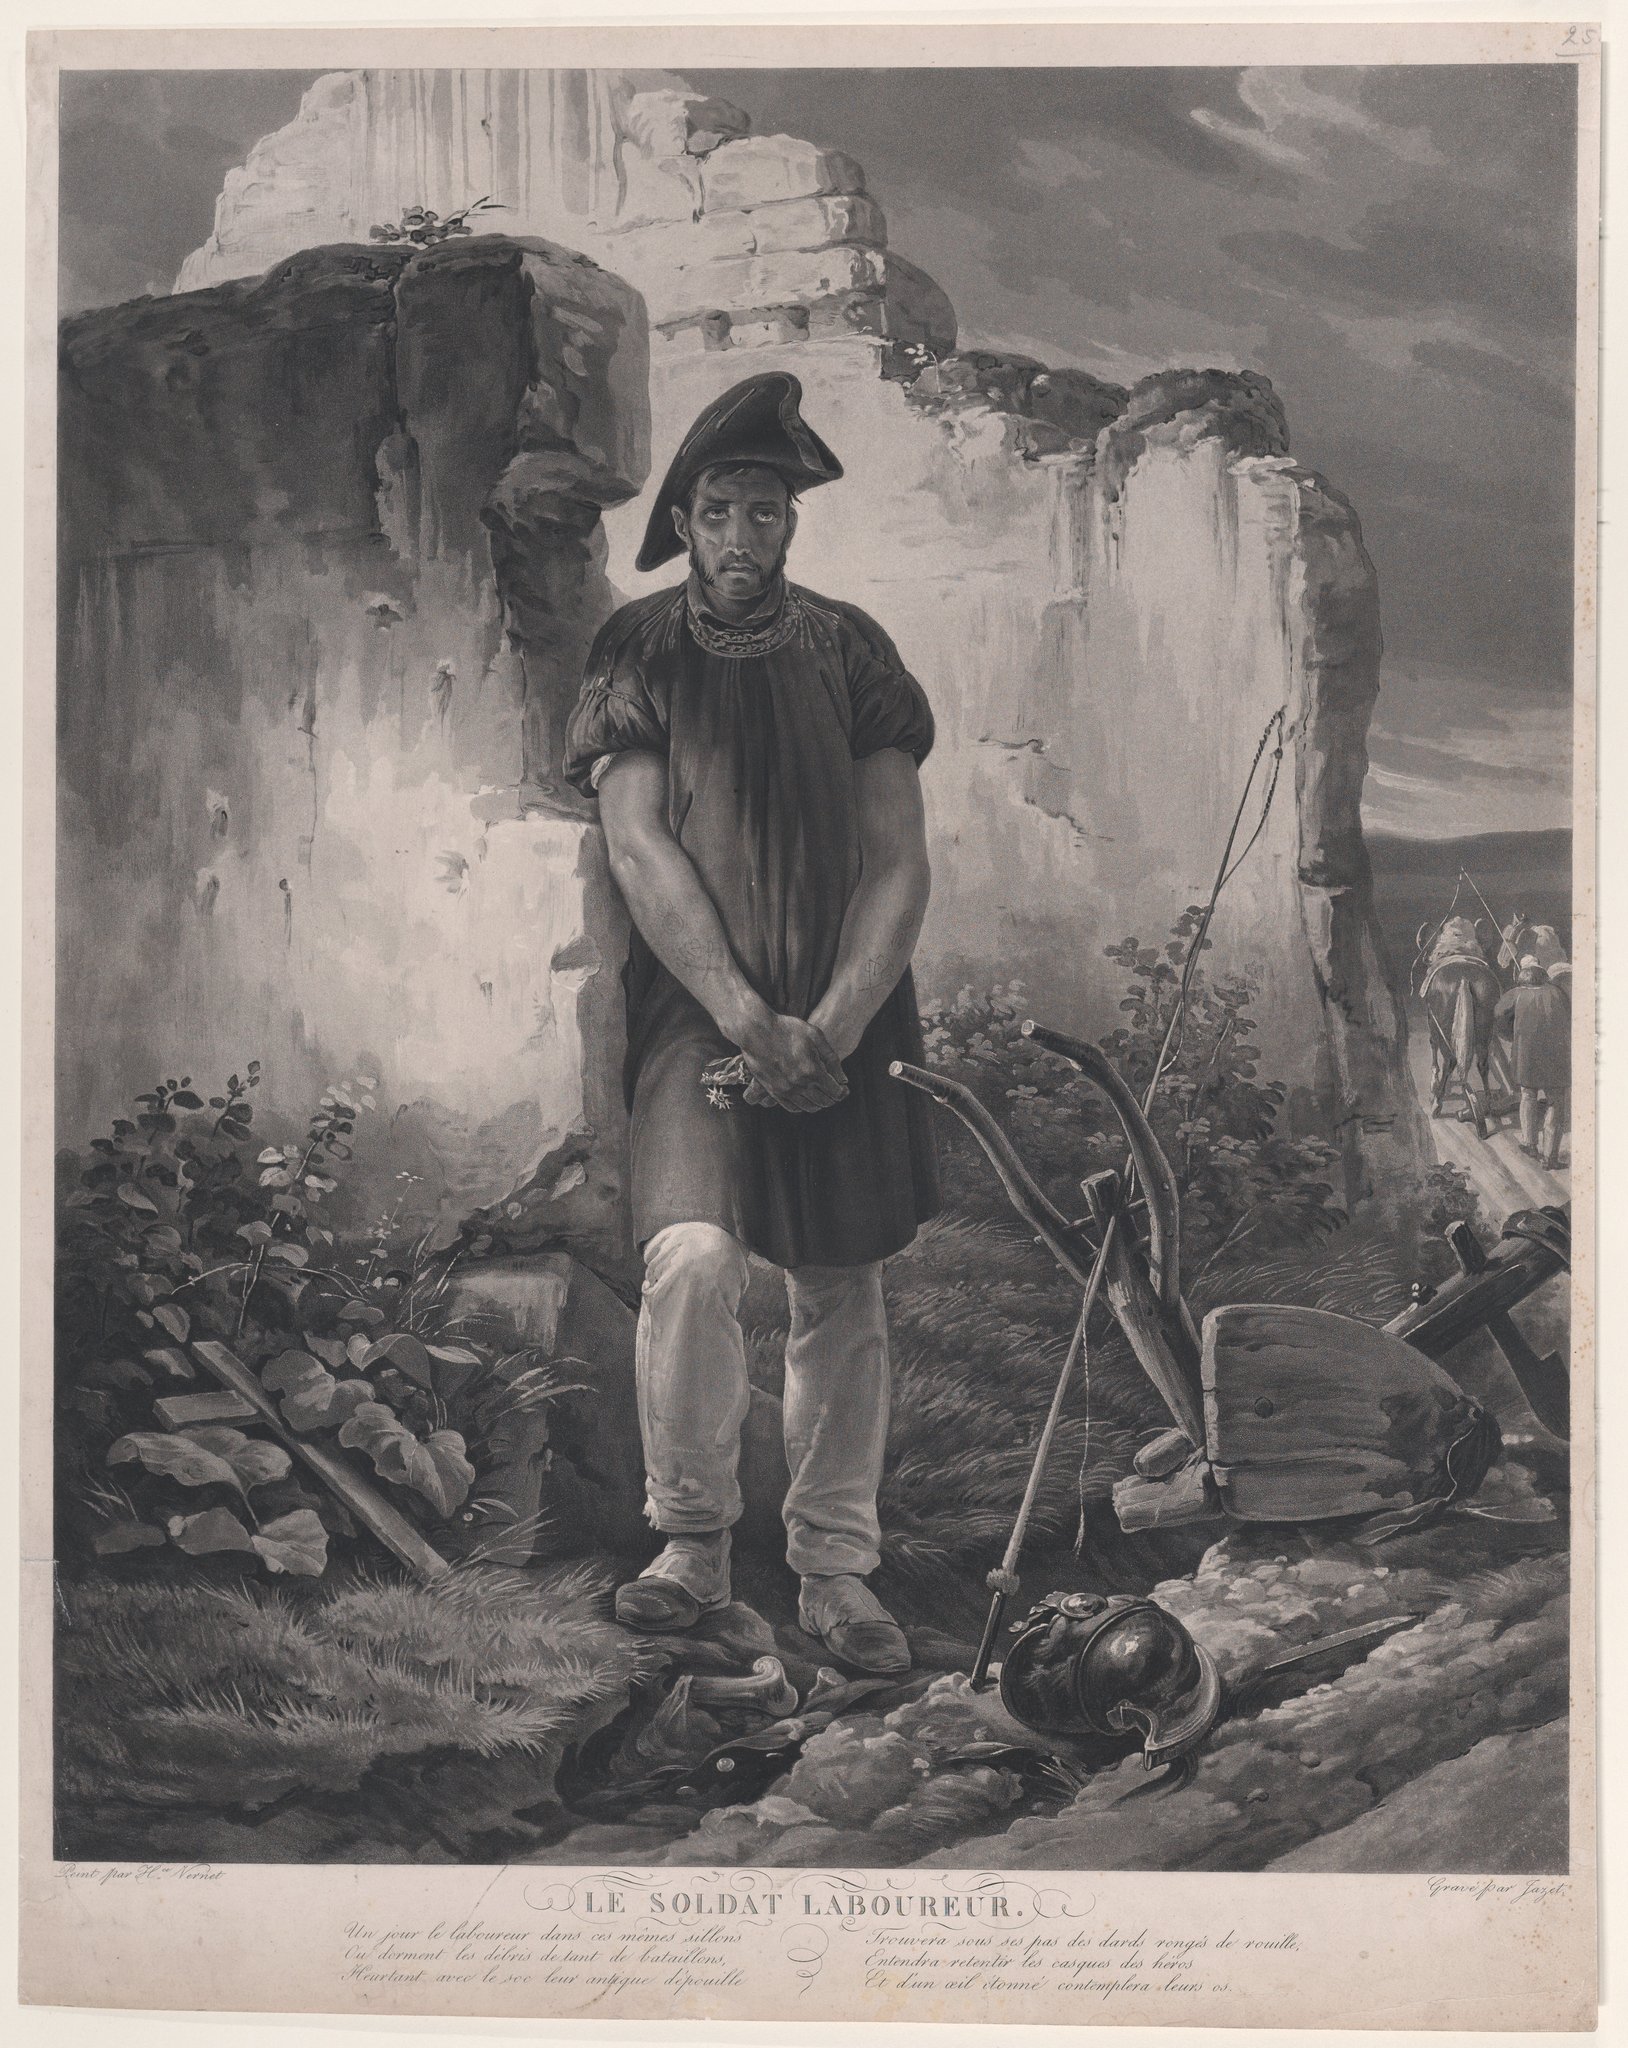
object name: print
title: The Plowing Soldier, after Horace Vernet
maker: jean pierre marie jazet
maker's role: artist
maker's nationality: french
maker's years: 1788-1871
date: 1821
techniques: lithograph